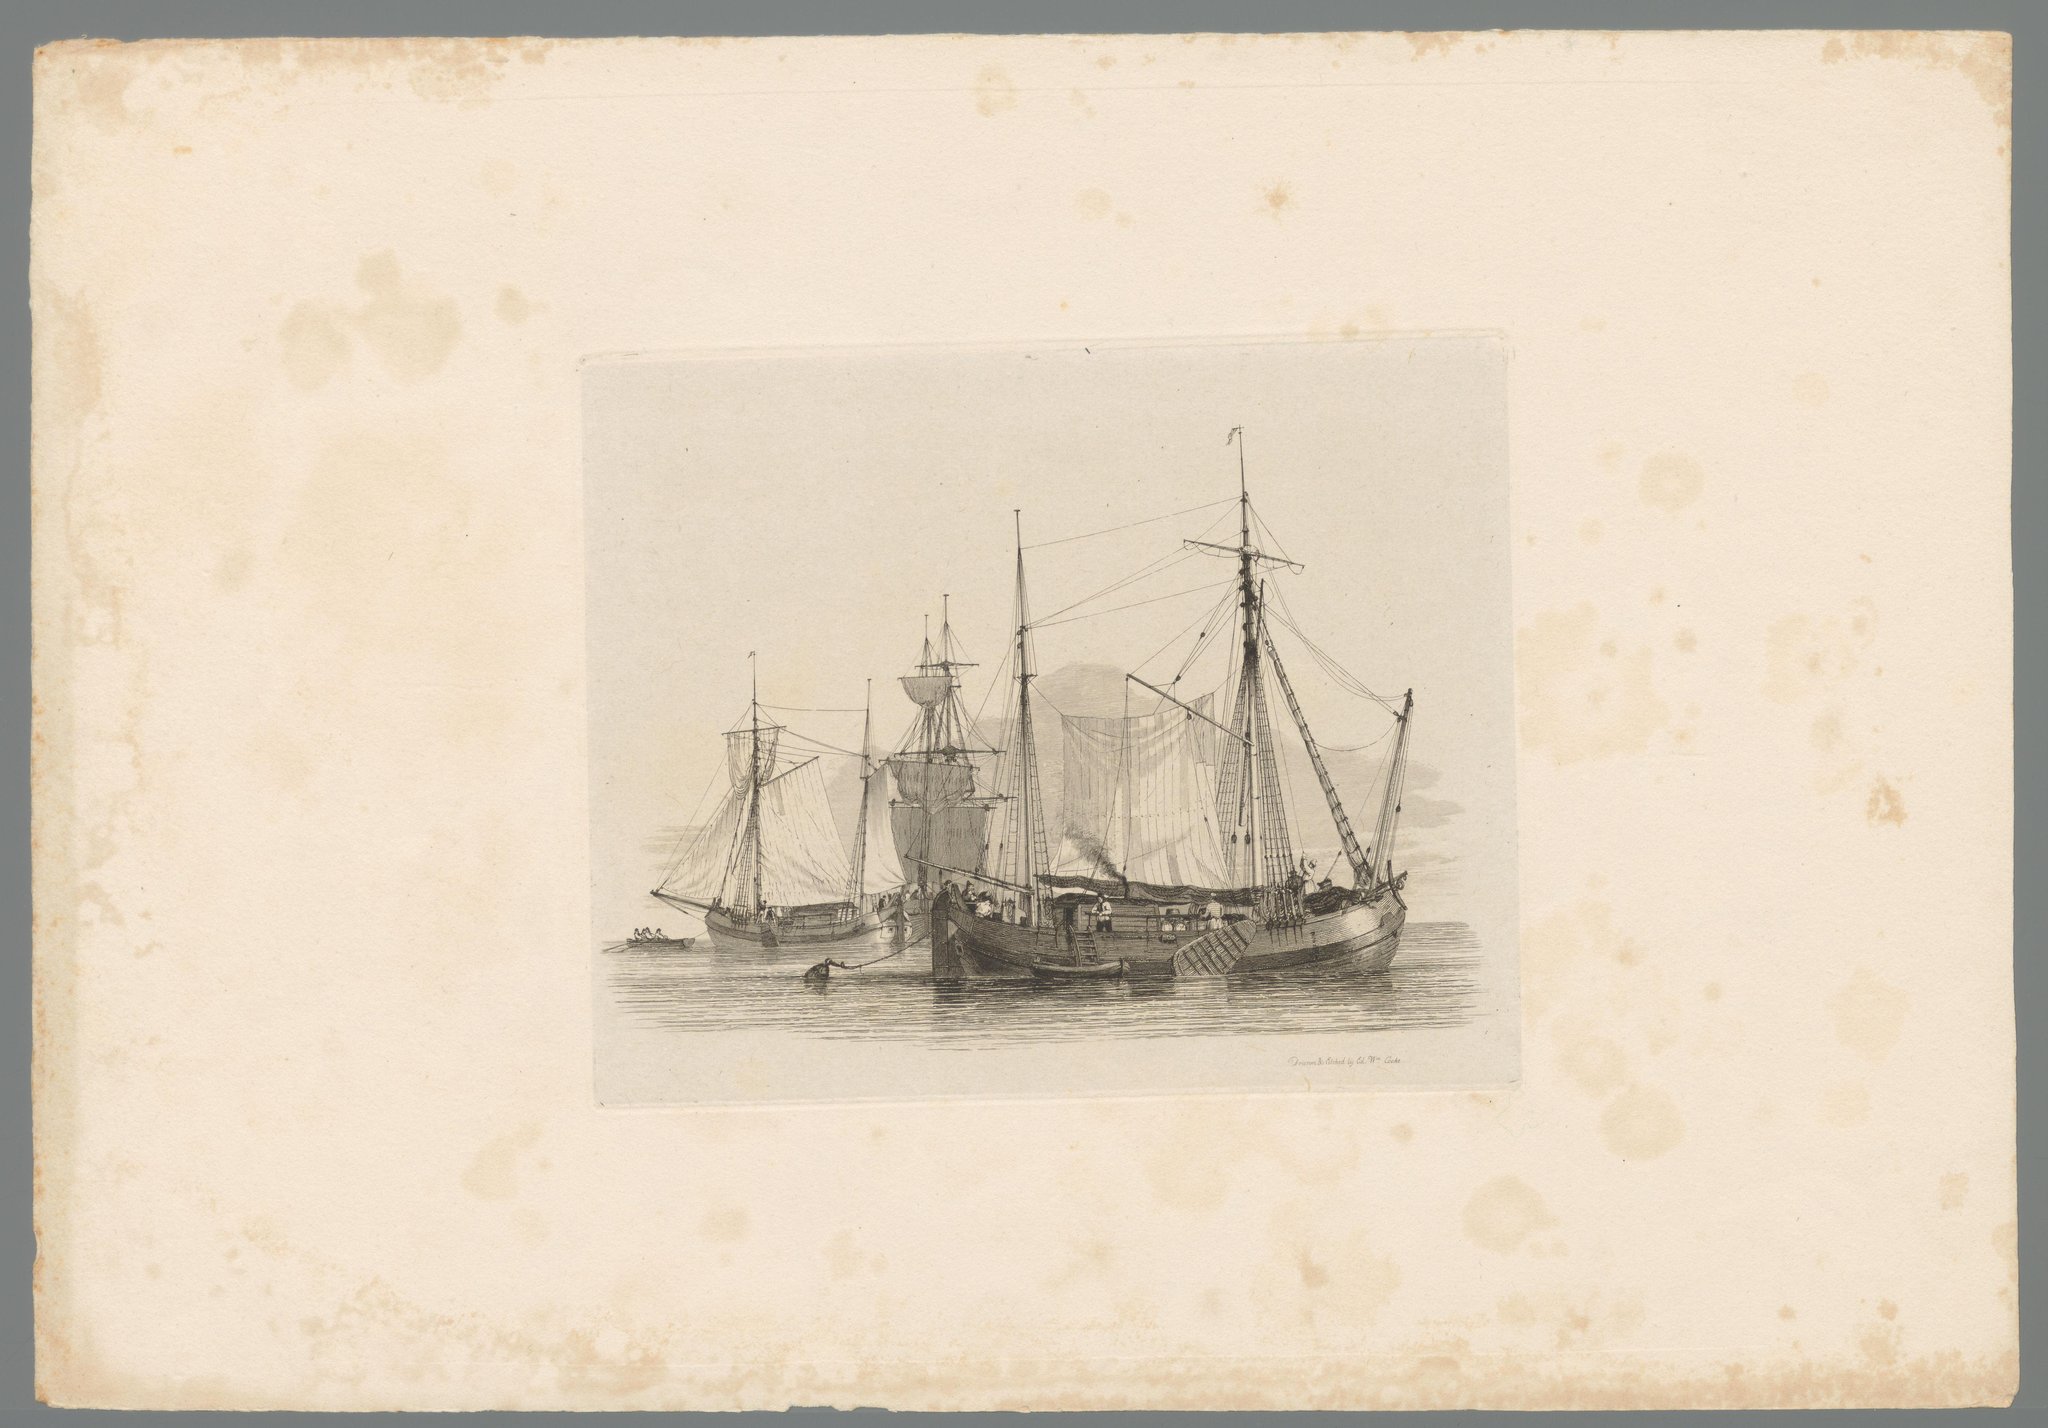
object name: print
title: Fifty Plates of Shipping and Craft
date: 1828-1829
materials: paper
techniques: etching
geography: london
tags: absence of wind, calm, sailing-ship, sailing-boat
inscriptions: collector's mark: Lugt 2165